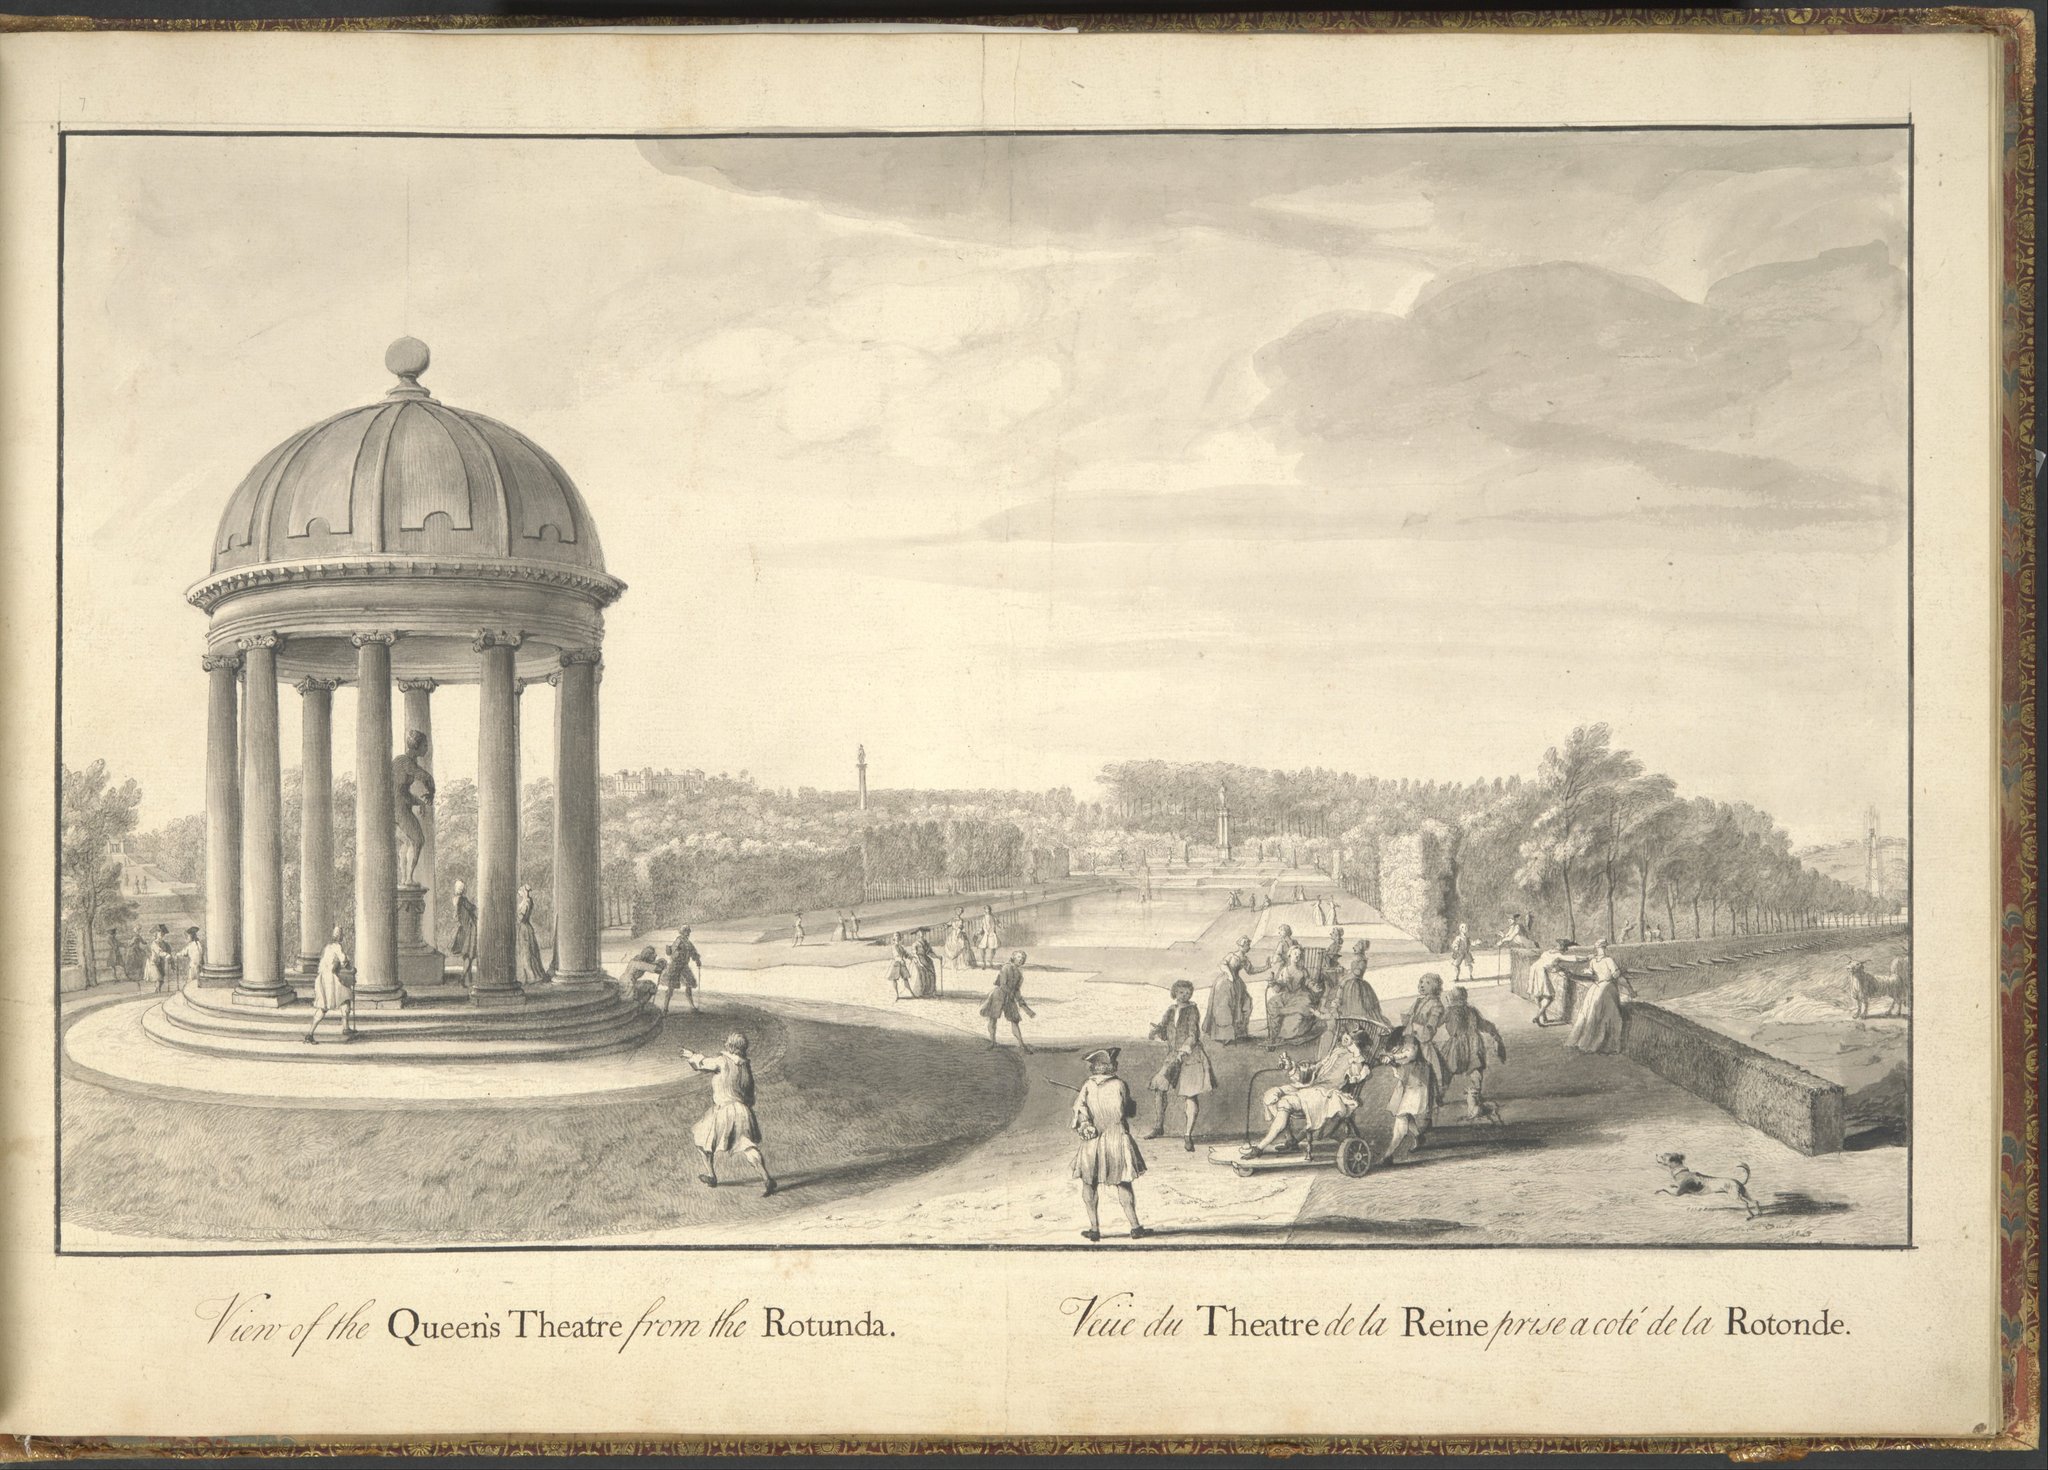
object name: album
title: A General Plan and Prospective of Lord Viscount Cobham's Gardens at Stowe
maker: jacques rigaud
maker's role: artist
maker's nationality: french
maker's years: 1681-1754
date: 1733-1734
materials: ink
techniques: brush, drawing, etching, pen, wash